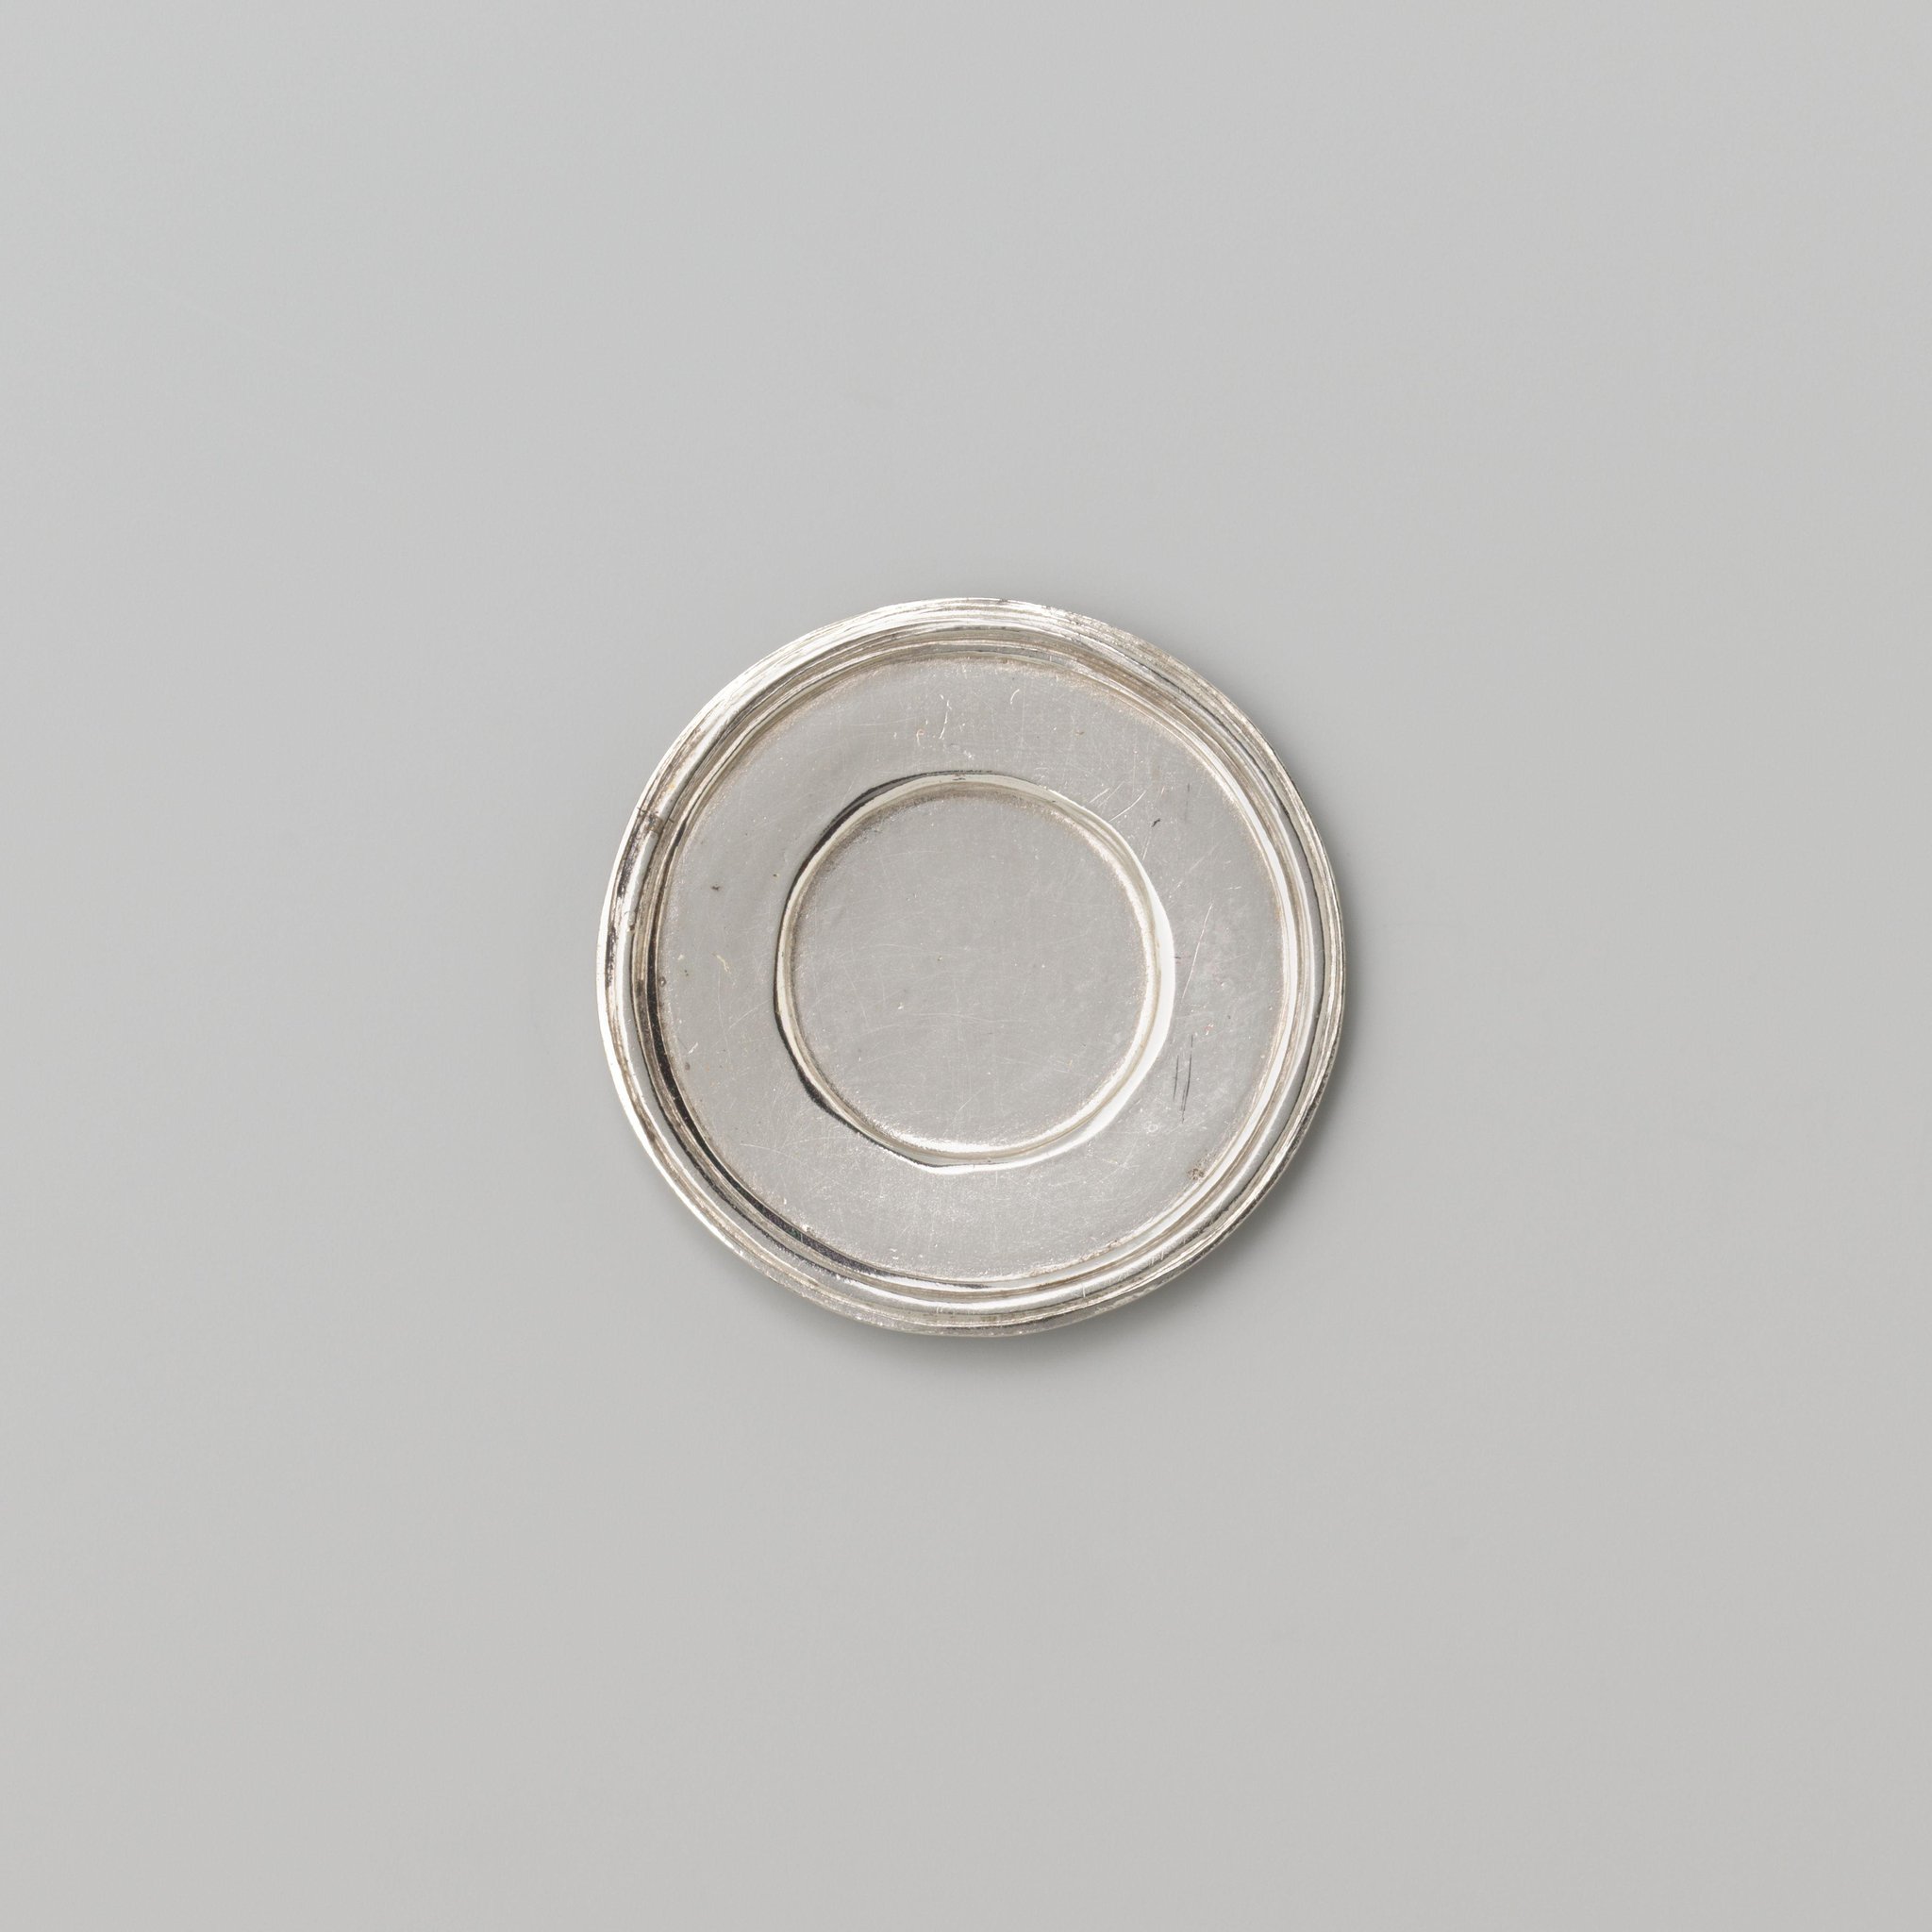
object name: miniature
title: Zilverkleurige schoteltje met brede platte geprofileerde rand.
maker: Anonymous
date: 1700-1710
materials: copper alloy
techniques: silvering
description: Zilverkleurige schotel met brede, platte geprofileerde rand.